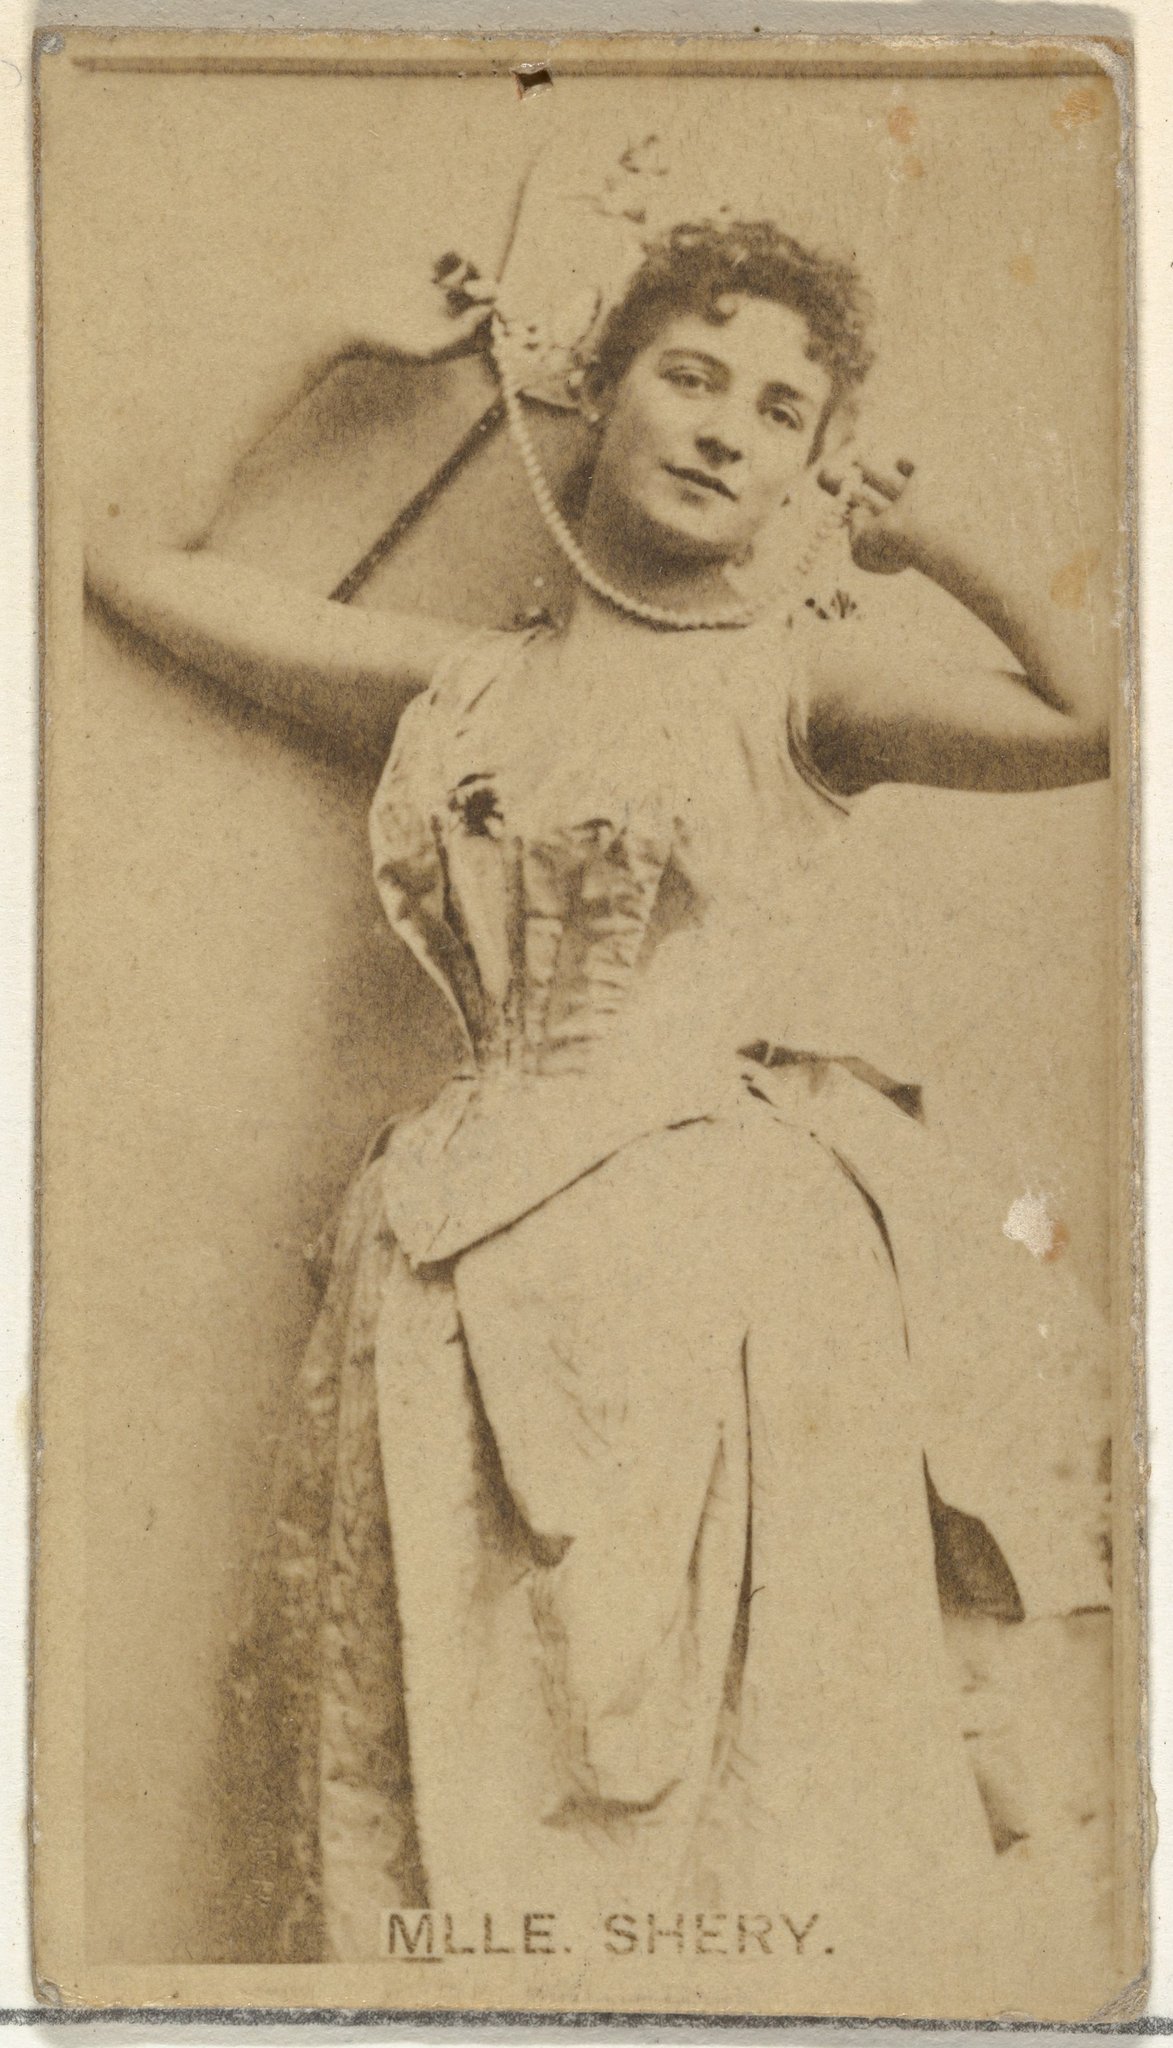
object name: photograph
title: Mlle. Shery, from the Actors and Actresses series (N145-8) issued by Duke Sons & Co. to promote Duke Cigarettes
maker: w. duke, sons & co.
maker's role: publisher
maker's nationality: american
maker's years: 1870-1920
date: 1891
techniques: albumen silver print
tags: portraits,women,actresses